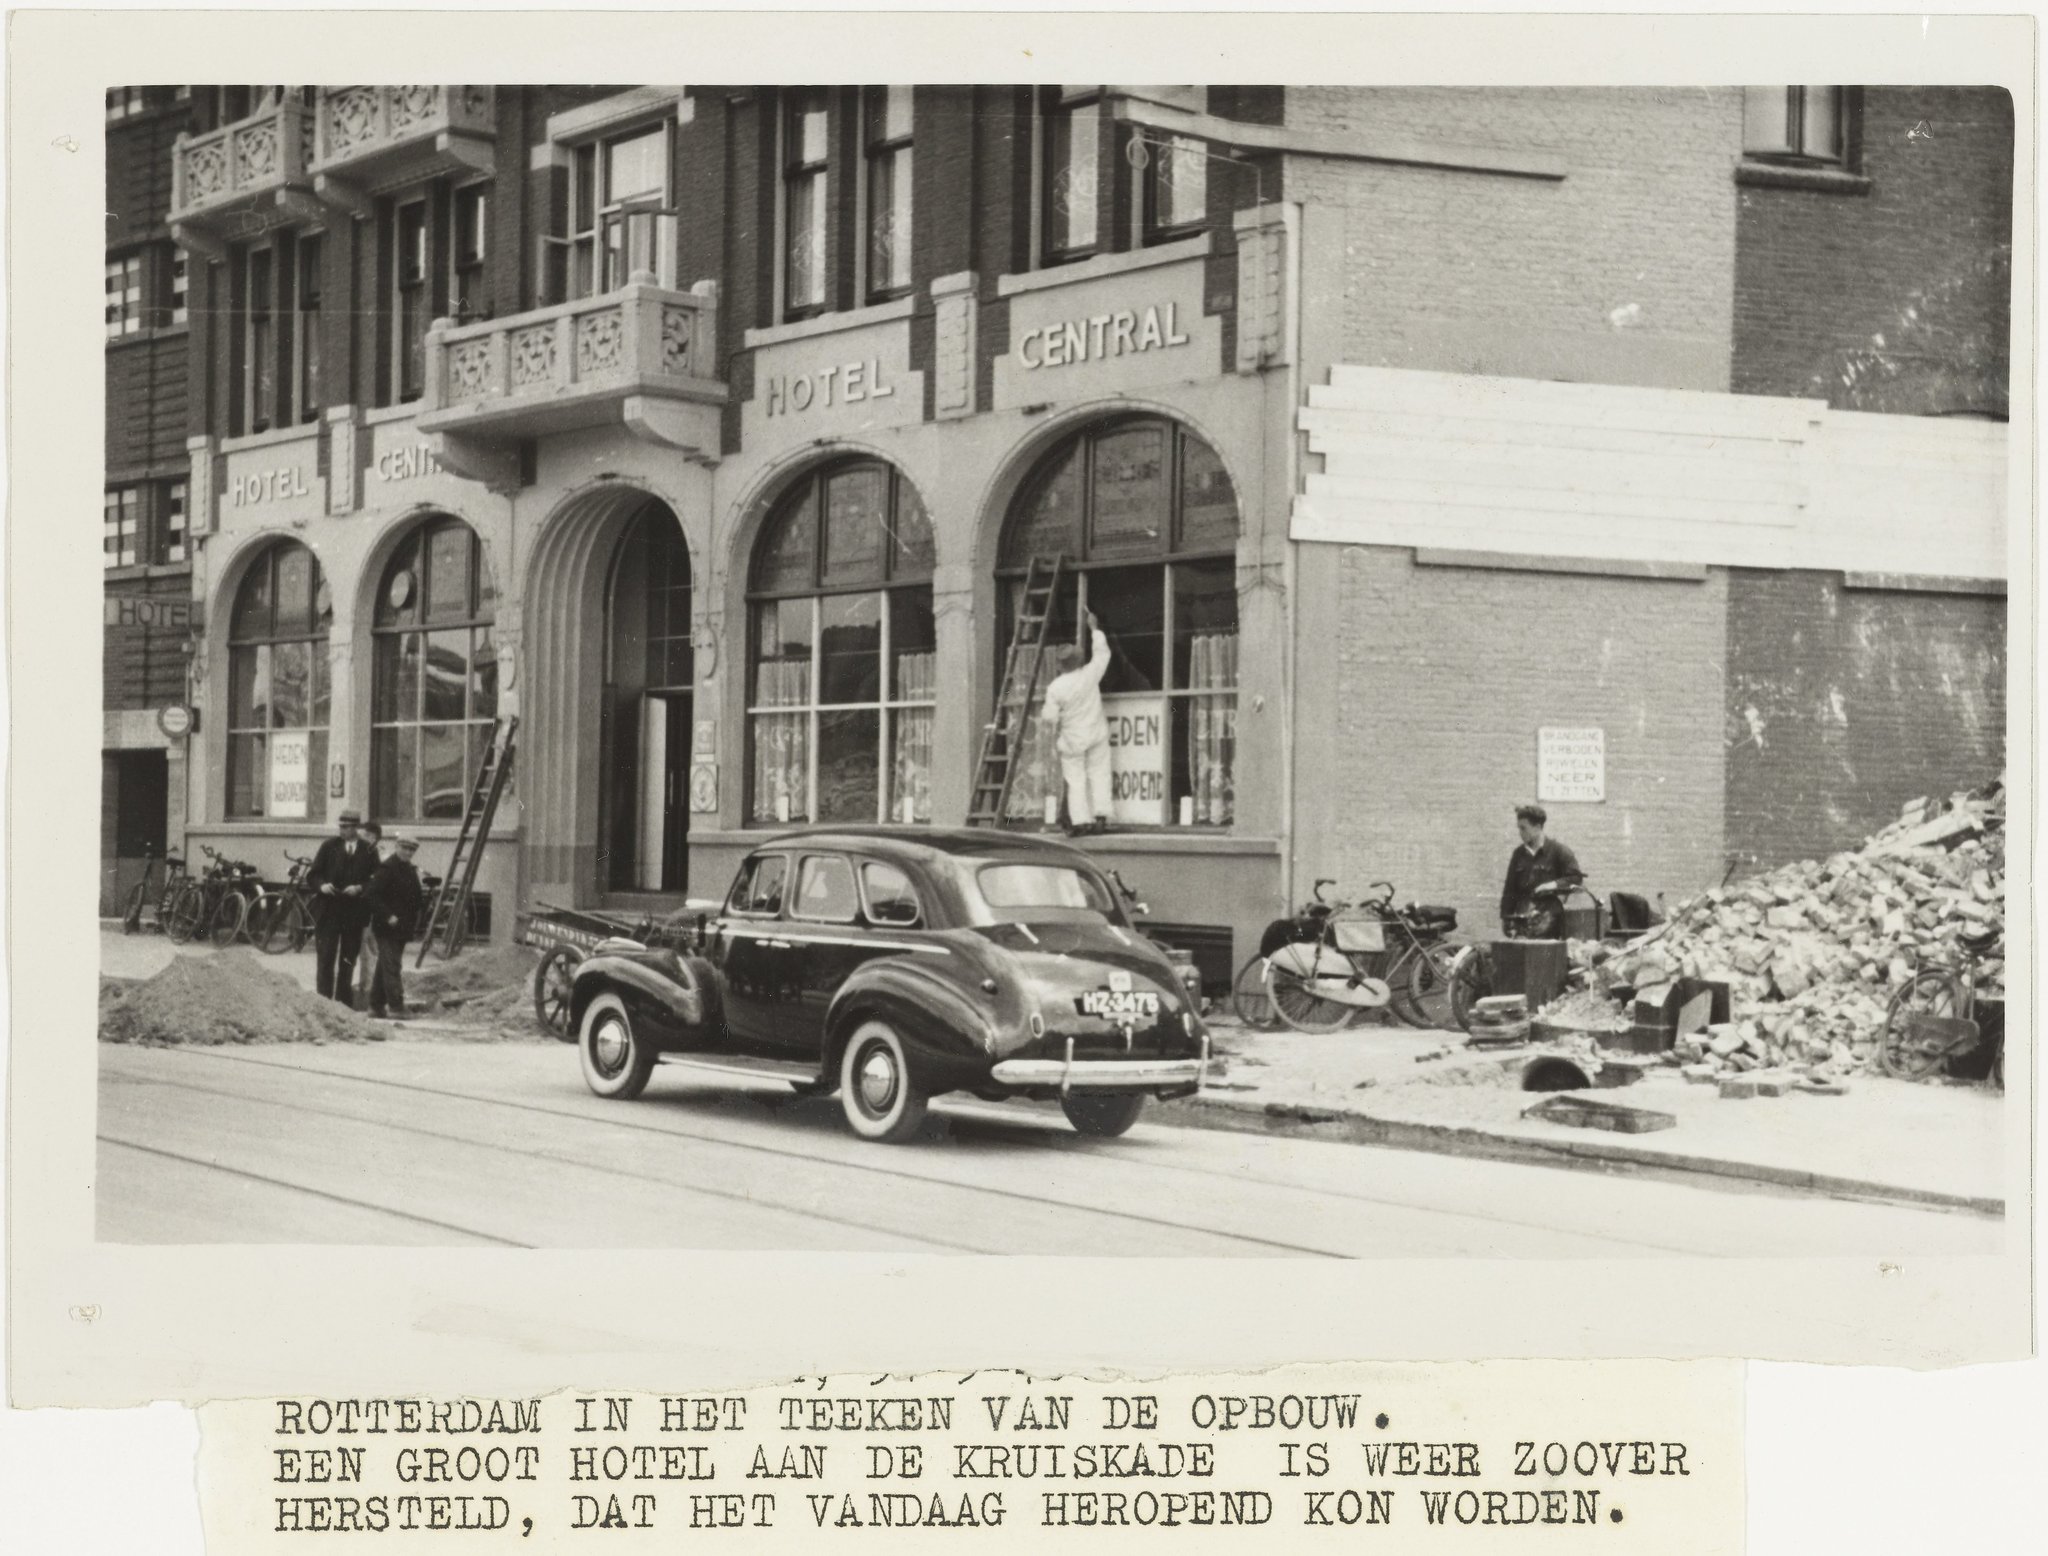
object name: photograph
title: Heropening hotel na het bombardement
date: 1940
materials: photographic support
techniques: photography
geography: rotterdam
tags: devastated, ruined place or city (~ warfare), rotterdam, rotterdam blitz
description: Hotel Central is licht getroffen tijdens het bombardement van 14 mei op Rotterdam en opent enige weken later alweer zijn deuren. Een schilder is nog bezig met herstelwerk. Tekststrookje aan foto geplakt.